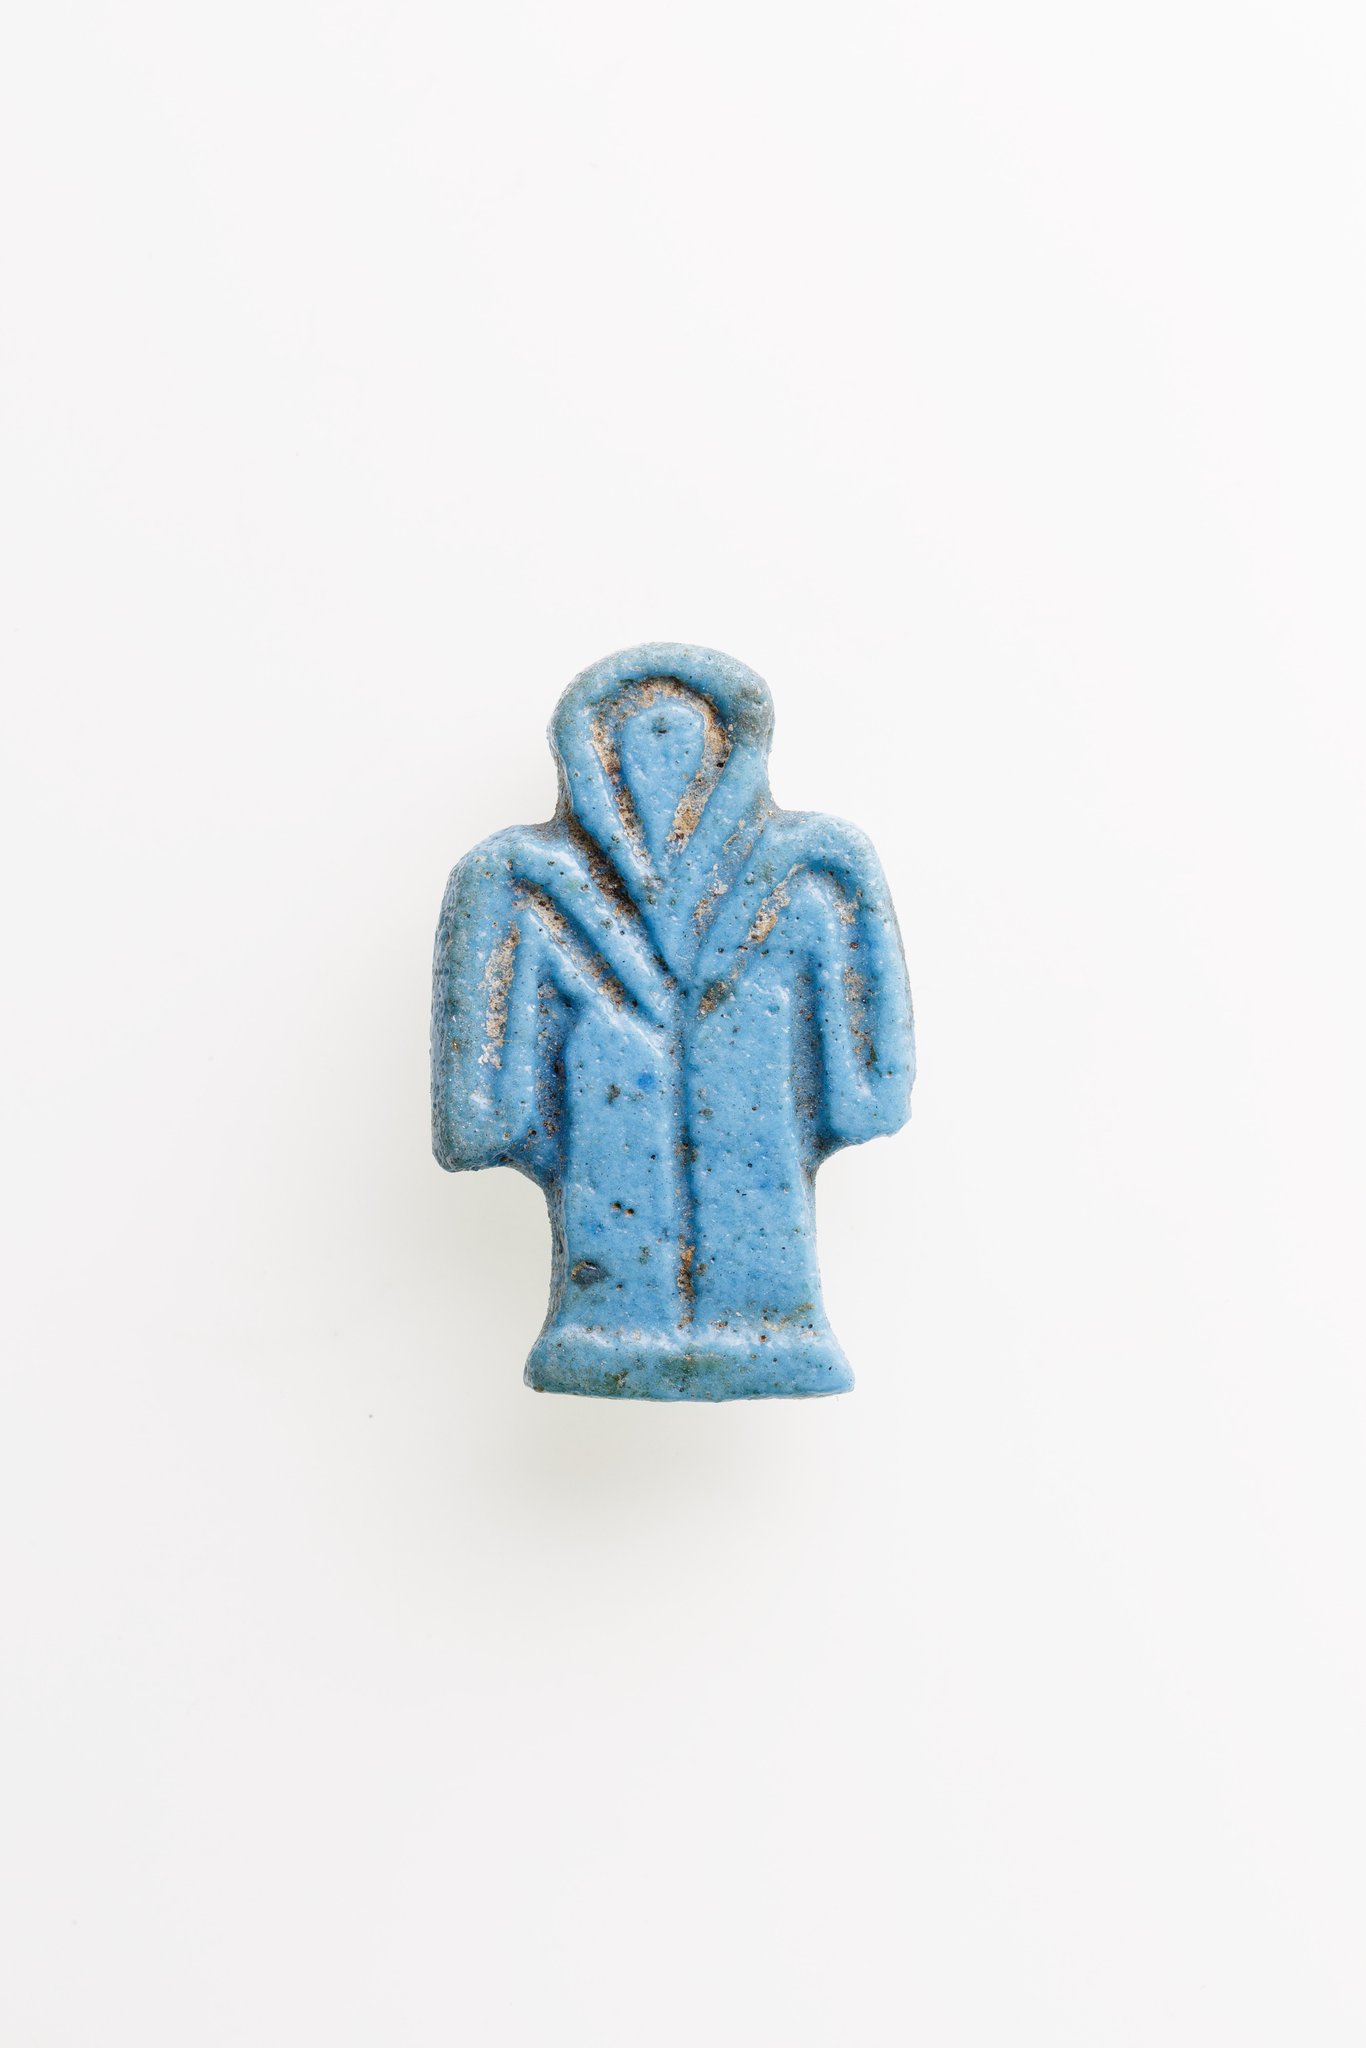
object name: amulet, tit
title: Tit amulet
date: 712-332 BCE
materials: faience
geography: egypt